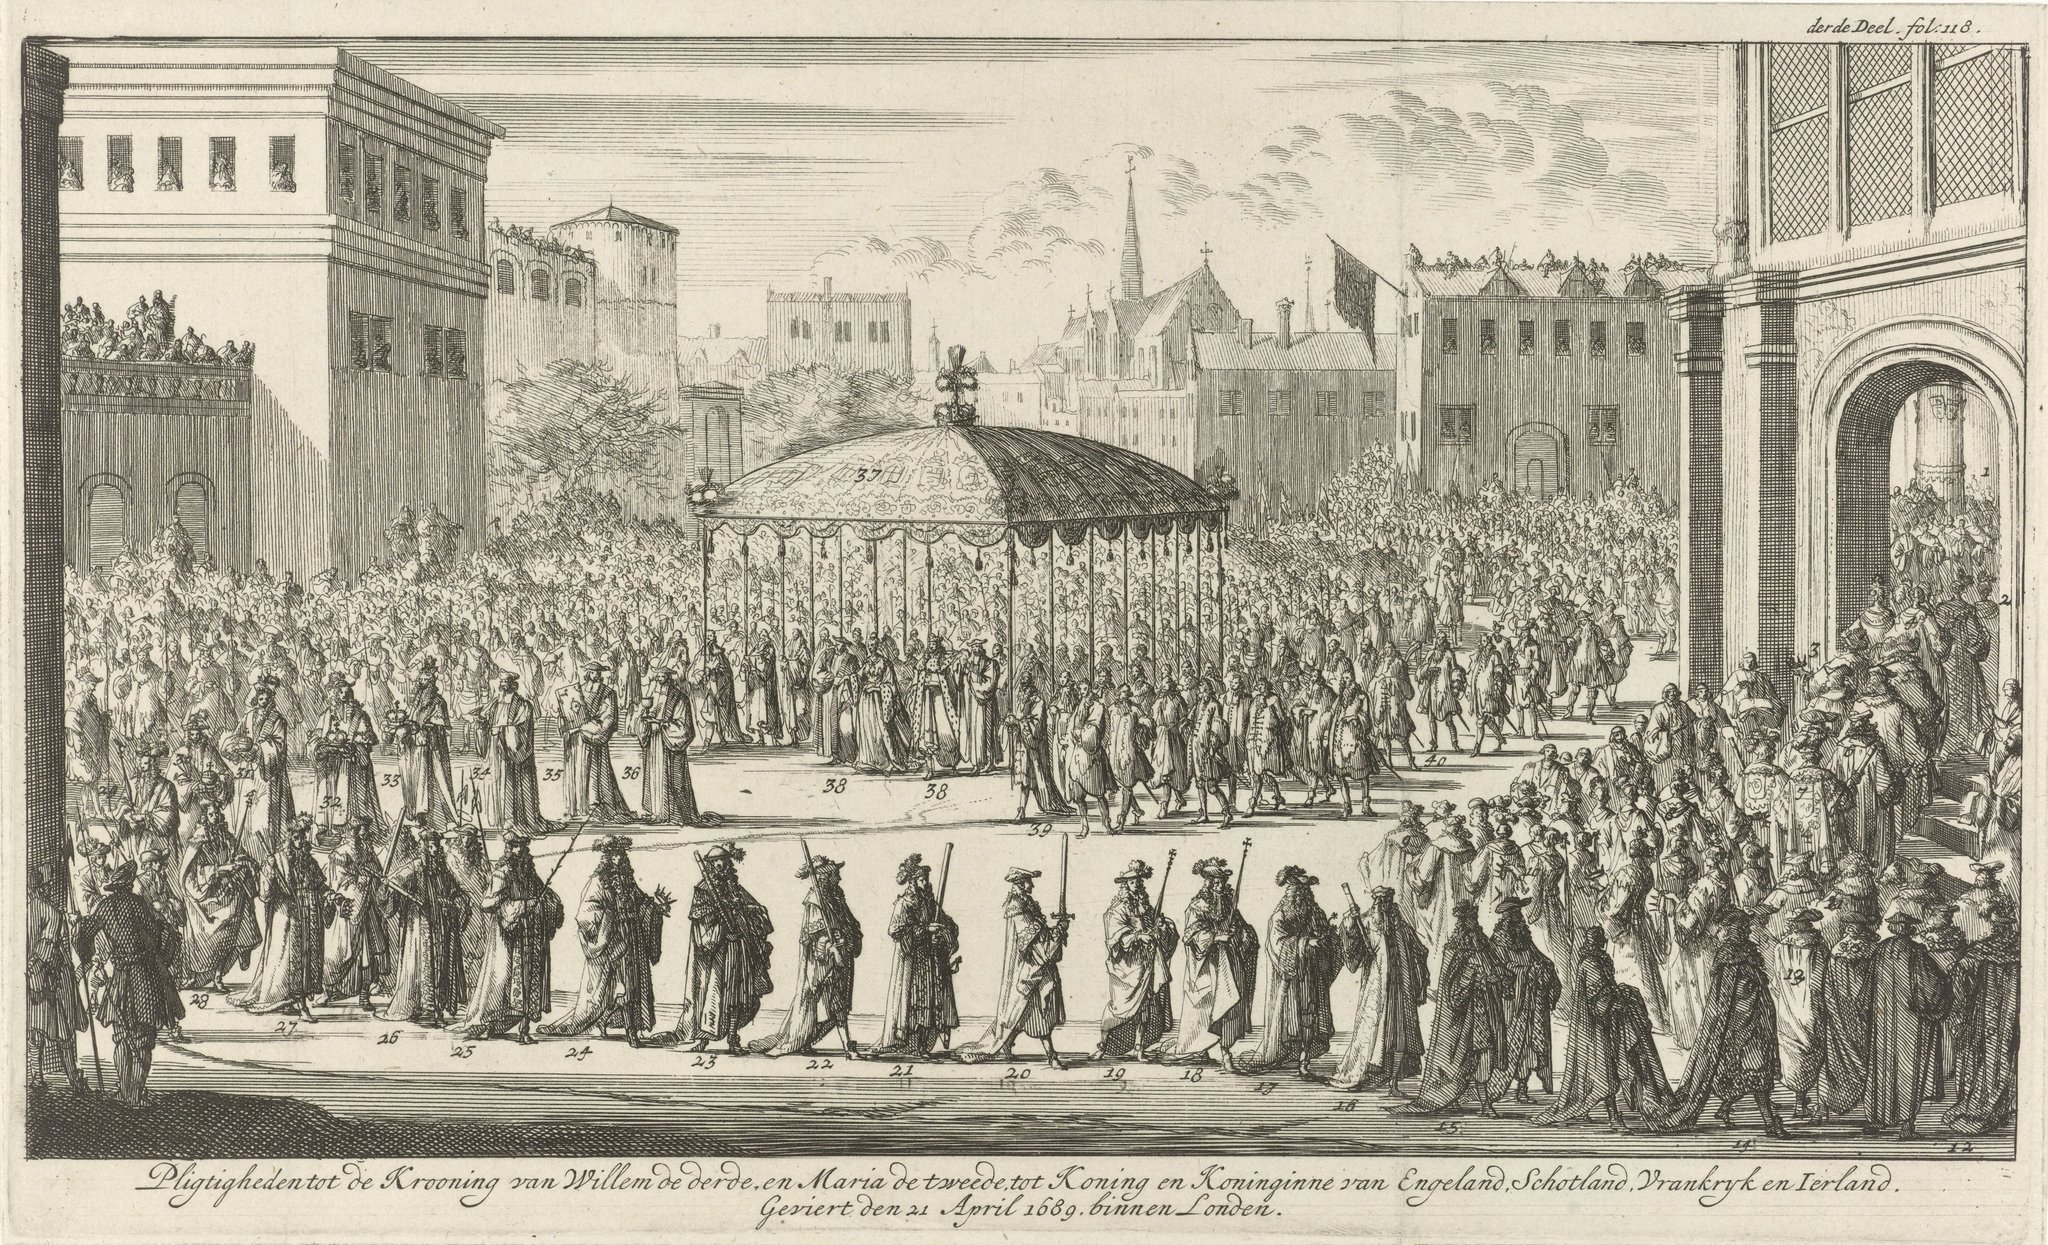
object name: book illustration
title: Pligtigheden tot de Krooning van Willem de derde, en Maria de tweede, tot Koning en Koninginne van Engeland, Schotland, Vrankryk en Ierland, Geviert den 21 April 1689 binnen Londen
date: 1689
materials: paper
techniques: etching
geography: amsterdam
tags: the hague, william iii (prince of orange and king of england, scotland, and ireland), london, maria ii stuart (koningin van engeland, schotland en ierland), coronation procession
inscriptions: collector's mark: Lugt 2228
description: Optocht naar de kroningsceremonie, 21 april 1689. Willem III en Maria II Stuart onder een baldakijn in een lange stoet onderweg naar Westminster Abbey. Met cijfers in de voorstelling en gemerkt rechtsboven: derde Deel. fol. 118.